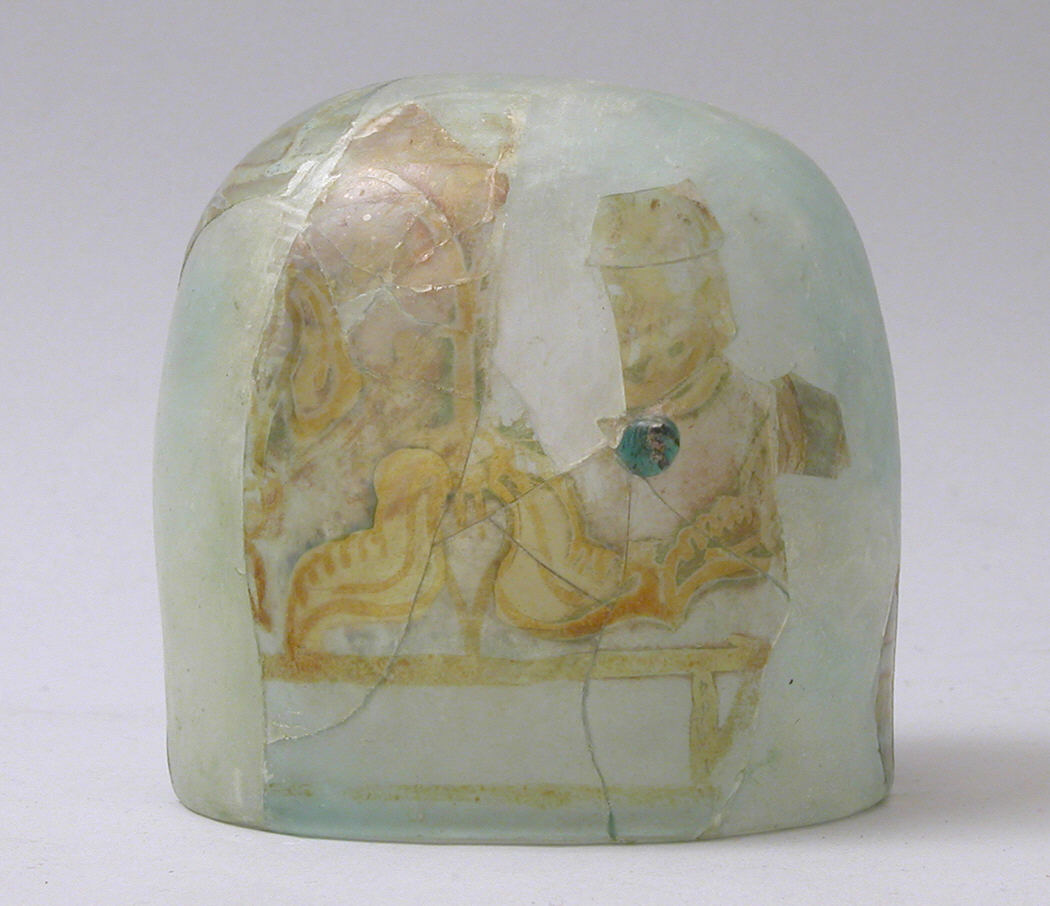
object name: cup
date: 801-900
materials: glass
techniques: luster painting, stain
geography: egypt or iraq